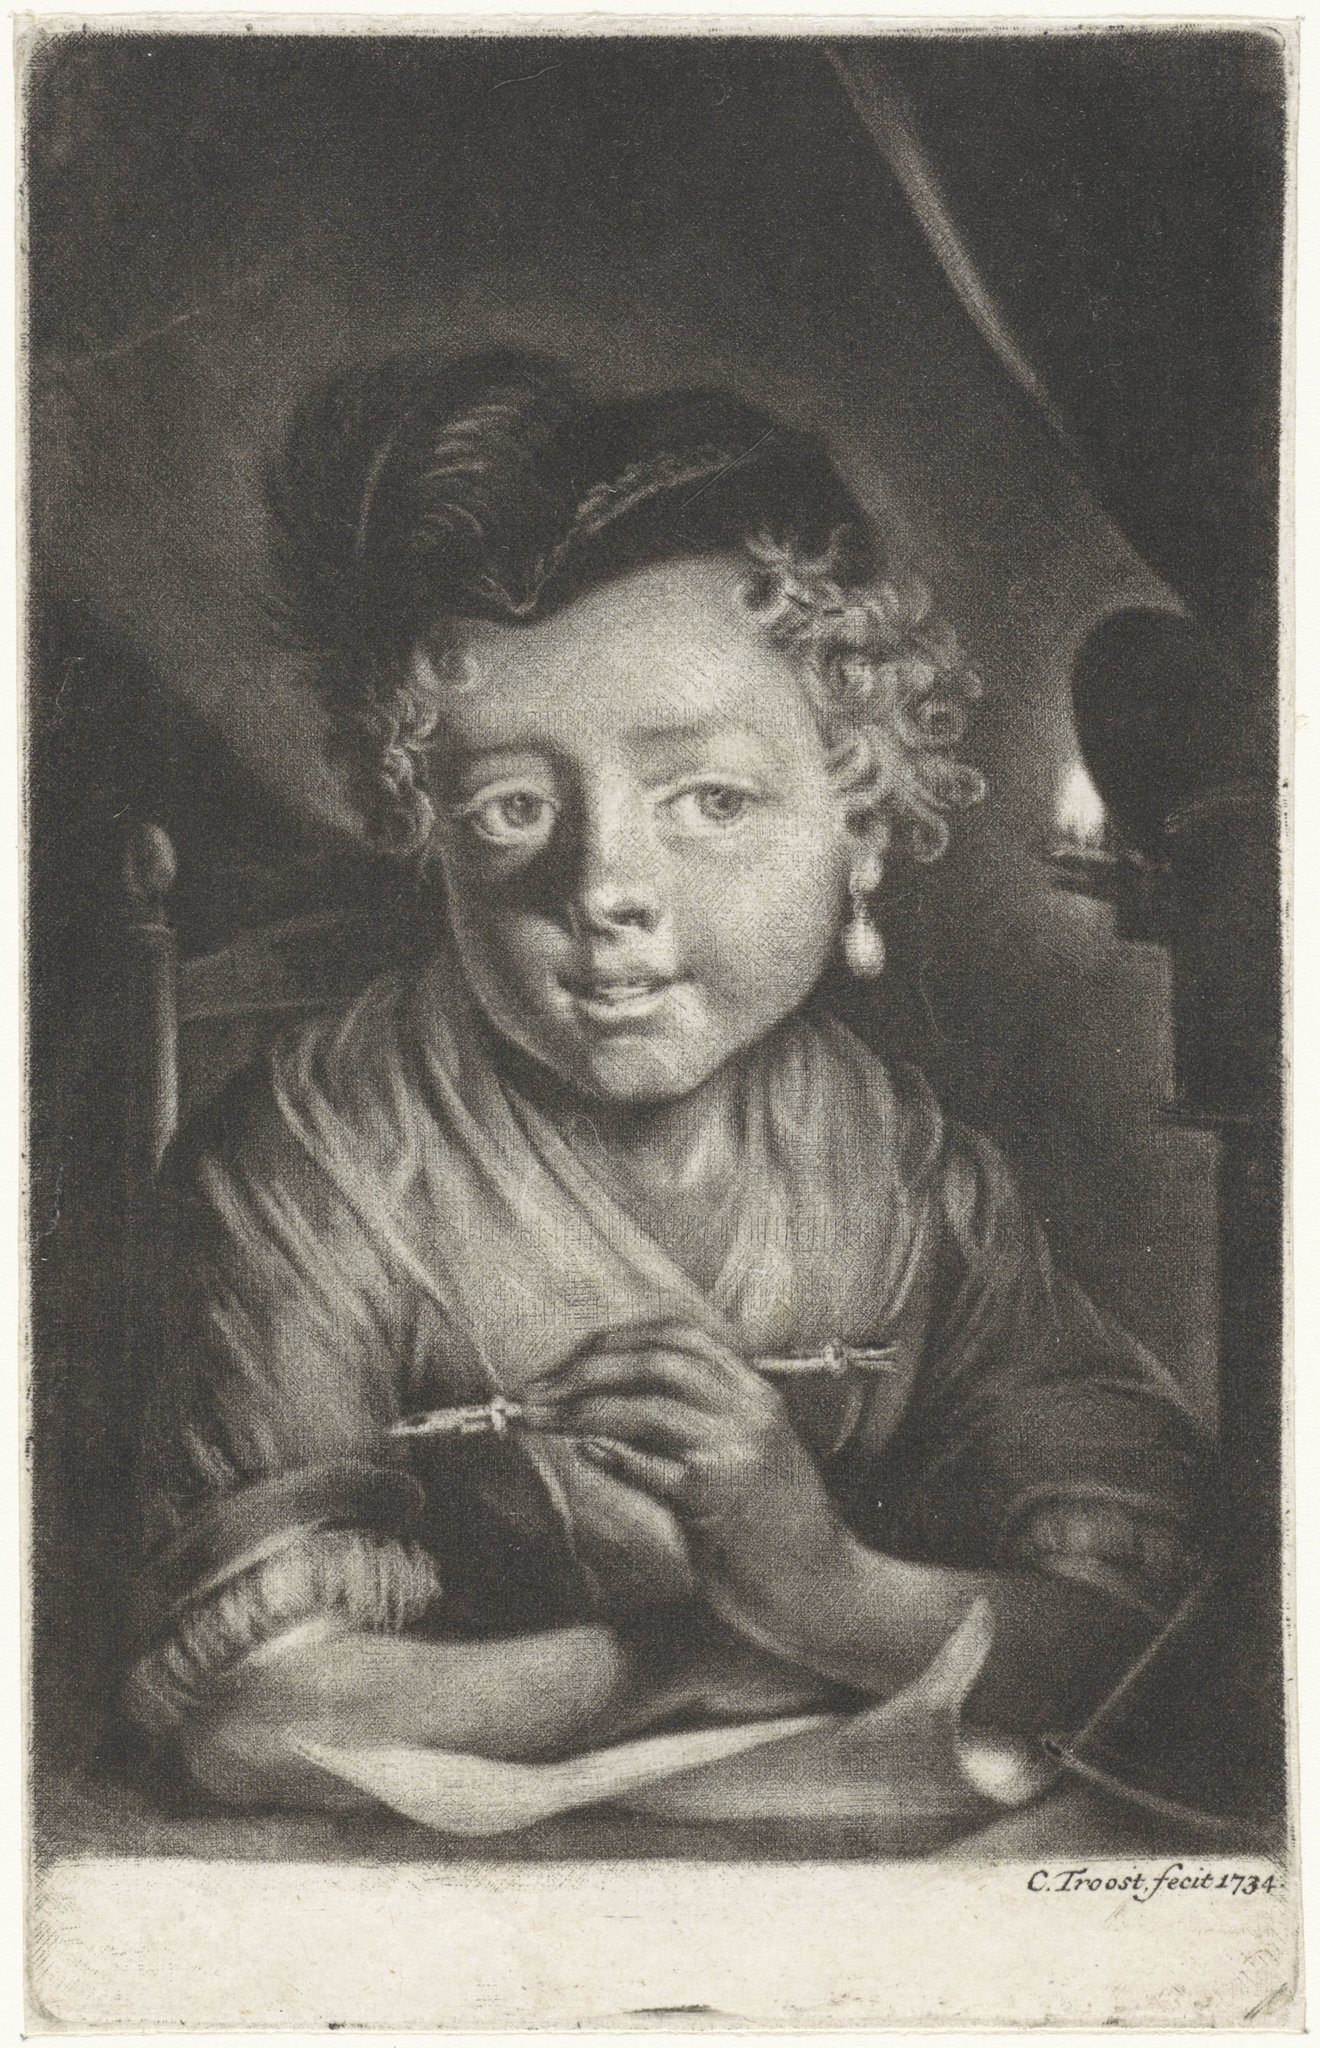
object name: print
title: Portret van een meisje, mogelijk Johanna Troost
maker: cornelis troost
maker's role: draughtsman, painter, print maker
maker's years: 1696-1750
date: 1734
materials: paper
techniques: mezzotint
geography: amsterdam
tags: handwriting, writing as activity, head-gear, pearl; pearl necklace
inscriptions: collector's mark: Lugt 2228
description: Een meisje, mogelijk Johanna Troost (de dochter van de kunstenaar) zit te schrijven. Ze draagt een hoedje en een parel in haar oor.